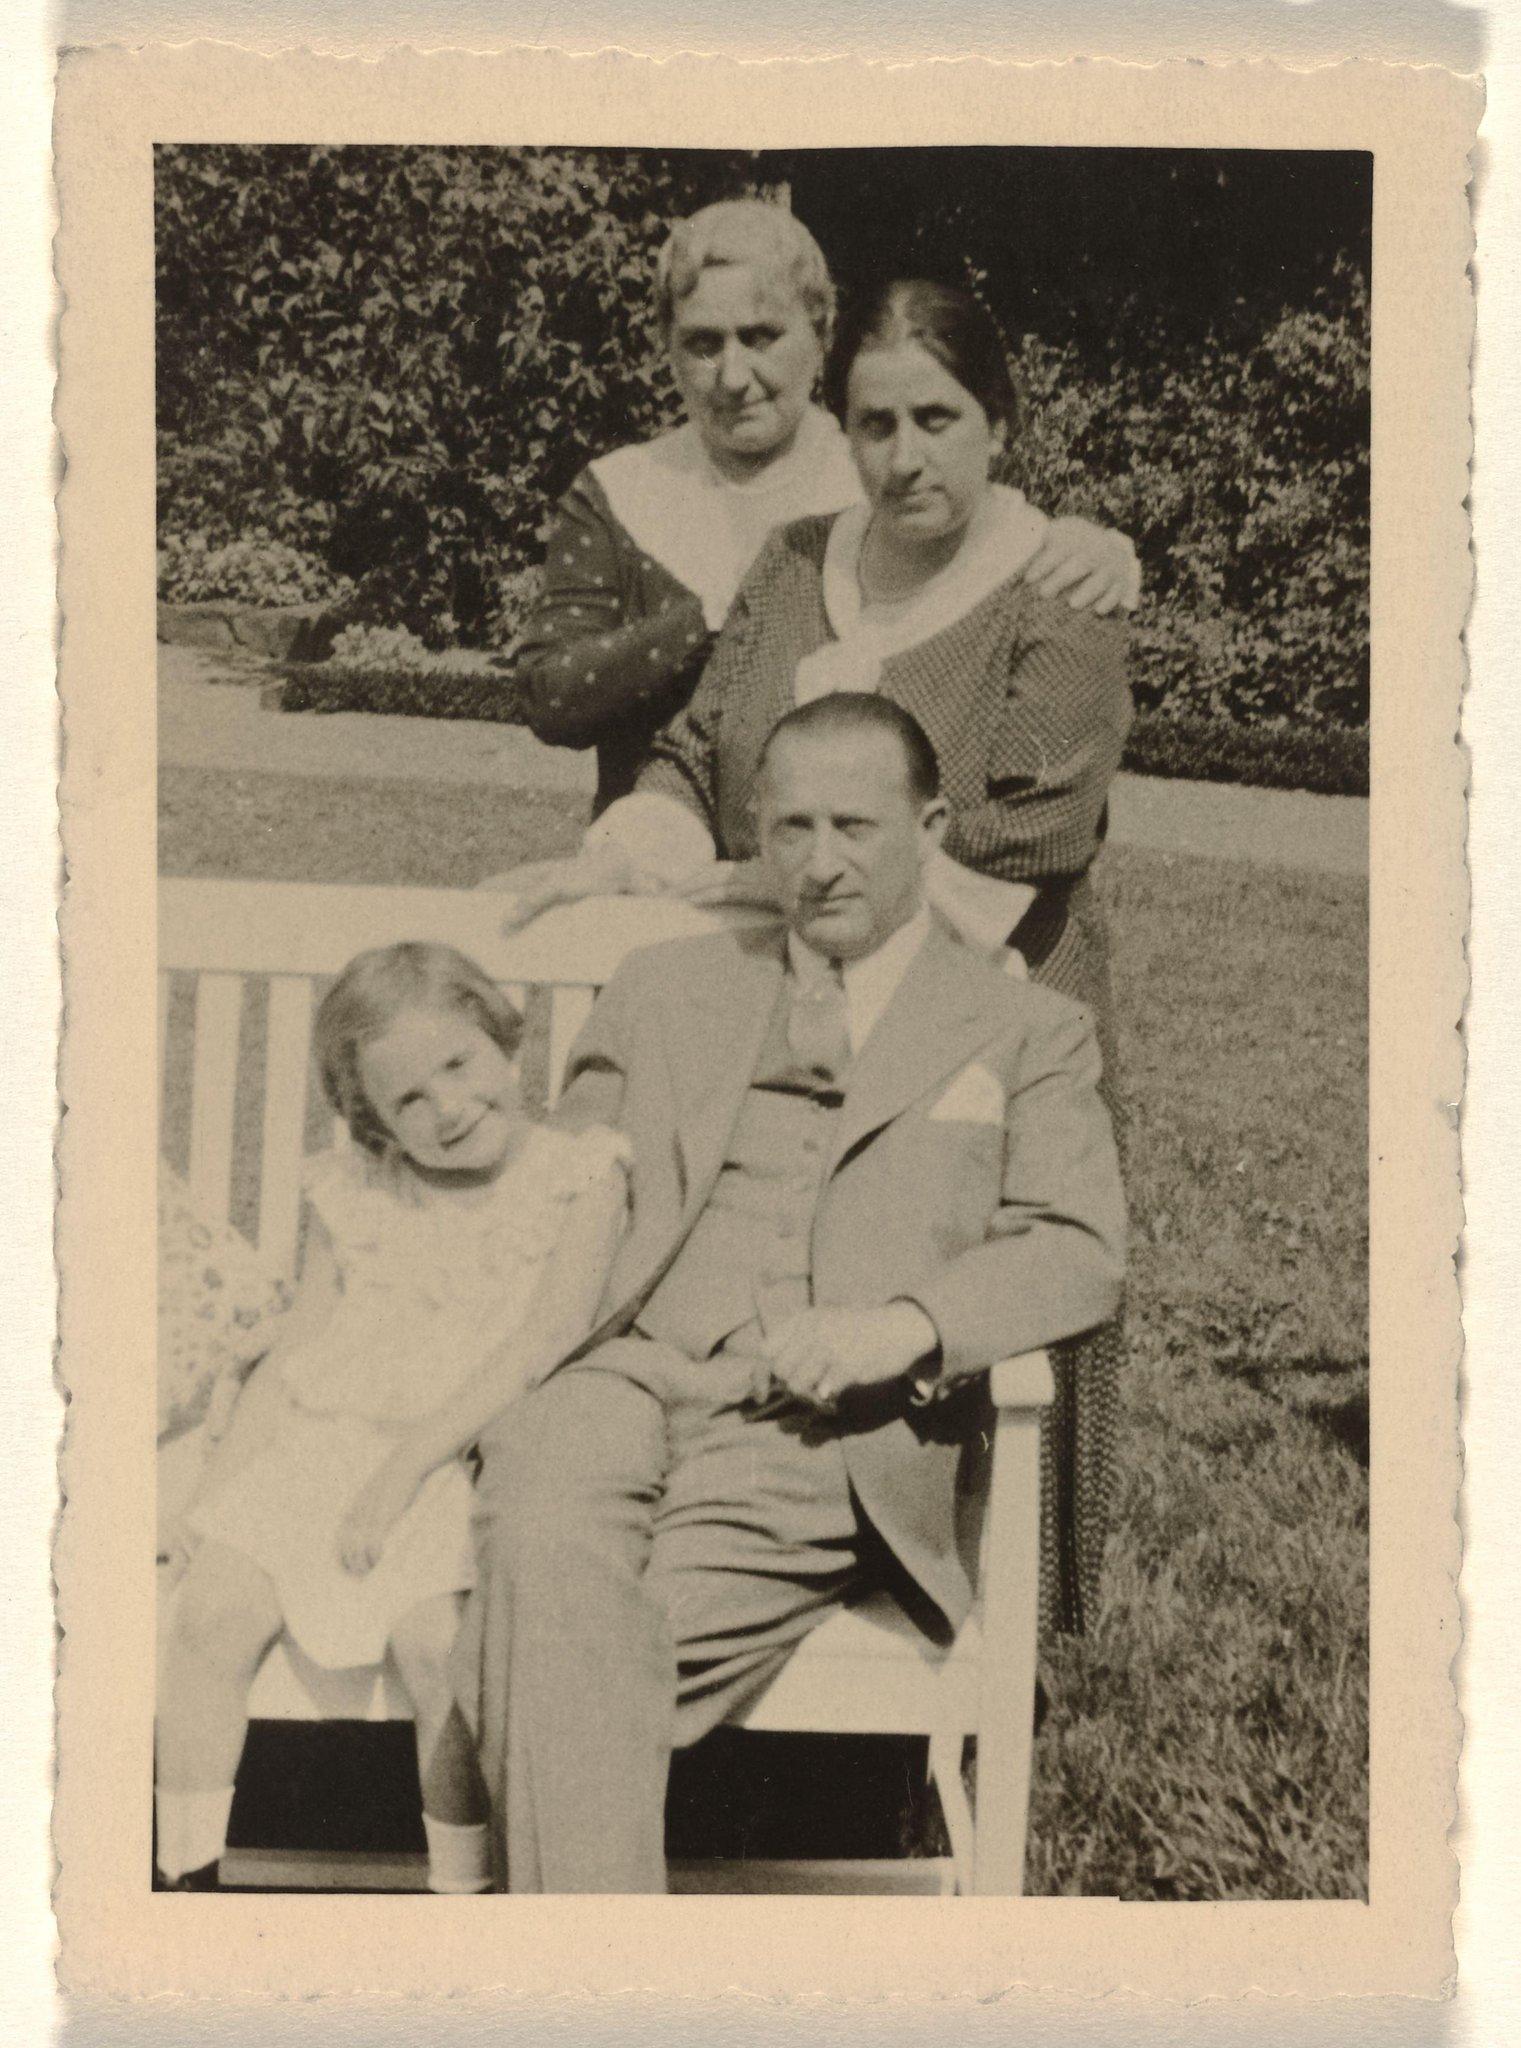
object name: photograph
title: Josefine Levi-Moos, Else Wachenheimer-Moos, Willy Moos en Isabel Wachenheimer gezeten in de tuin van Willy Moos in Hamburg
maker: Anonymous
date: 1928-1937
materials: photographic support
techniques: gelatin silver print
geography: hamburg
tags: else wachenheimer-moos, leiden, isabel wachenheimer-elon, willy moos, josefine moos-levi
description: Dit object is onderdeel van de nalatenschap van Isabel Elon-Wachenheimer (1928-2010). Tot haar overlijden behoorde het samen met de andere objecten uit de nalatenschap tot haar privédomein van Isabel Wachenheimer. In die particuliere context zijn deze objecten tezamen en individueel aandenkens - aan de jeugd, ouders en familie van Isabel Wachenheimer vóór en tijdens de Shoah en aan haar leven na de Tweede Wereldoorlog. Isabel Wachenheimer, die van juni 1943 tot mei 1945 gevangen zat in Kamp Westerbork, Theresienstadt, Auschwitz, Lenzing a/d Oberdonau (een buitenkamp van Mauthausen), overleefde de Shoah. Haar ouders – Eugène Wachenheimer en Else Wachenheimer-Moos - werden op 14 oktober 1944 in Auschwitz-Birkenau vermoord.